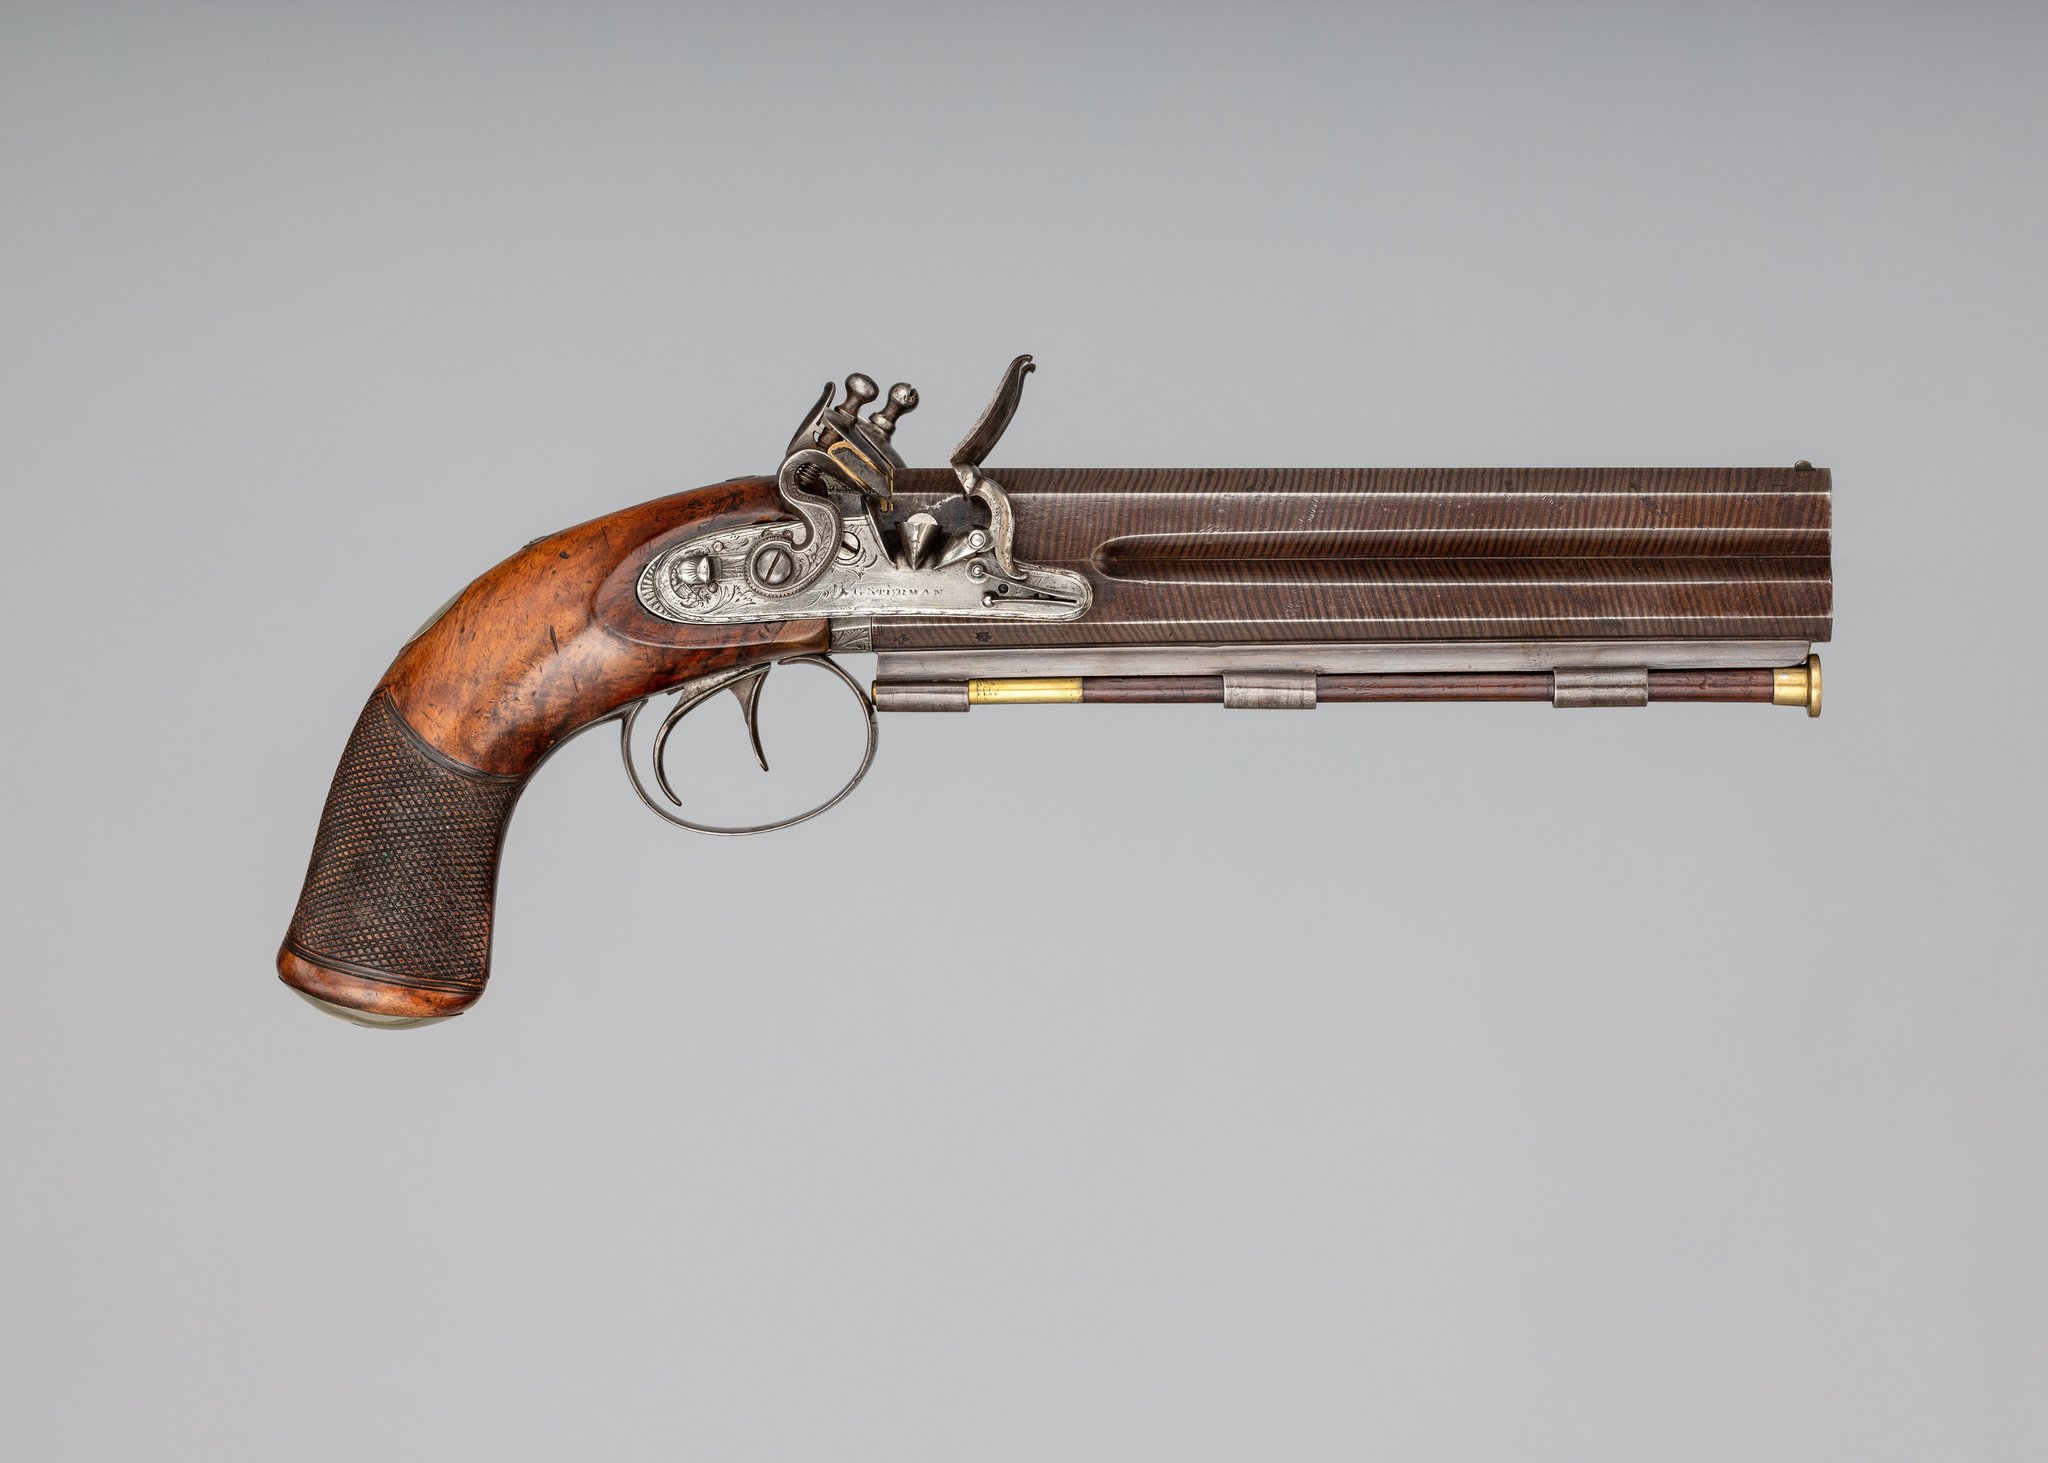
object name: flintlock pistol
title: Over-and-Under Flintlock Pistol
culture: british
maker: george sturman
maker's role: gunsmith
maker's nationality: british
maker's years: 1800-1875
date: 1841-1848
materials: brass, platinum, steel, wood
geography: england